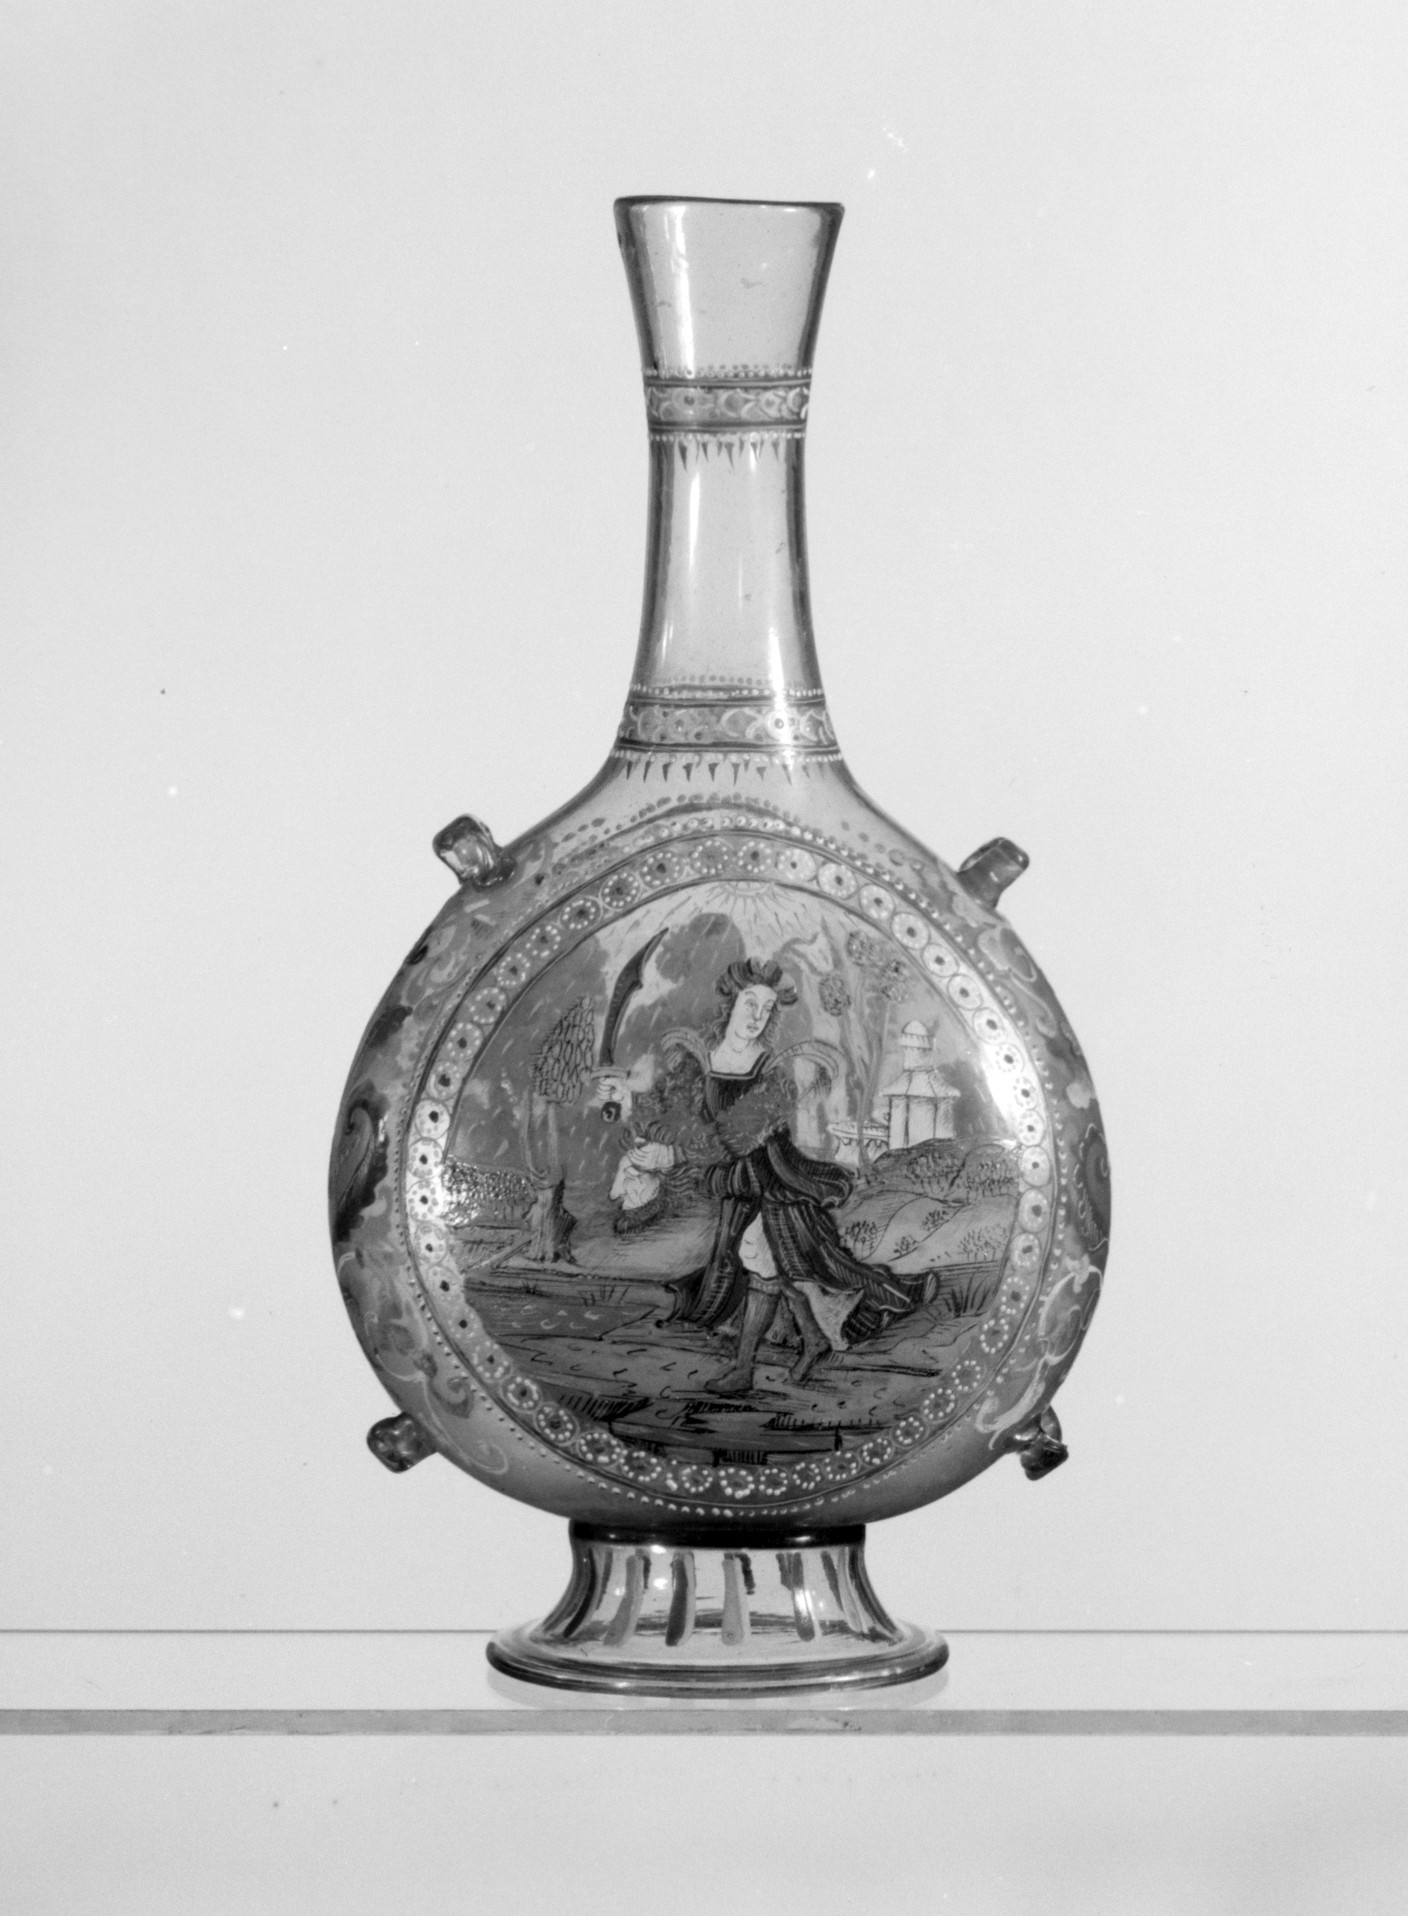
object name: pilgrim bottle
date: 1801-1900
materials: gilt, glass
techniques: enamel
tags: women